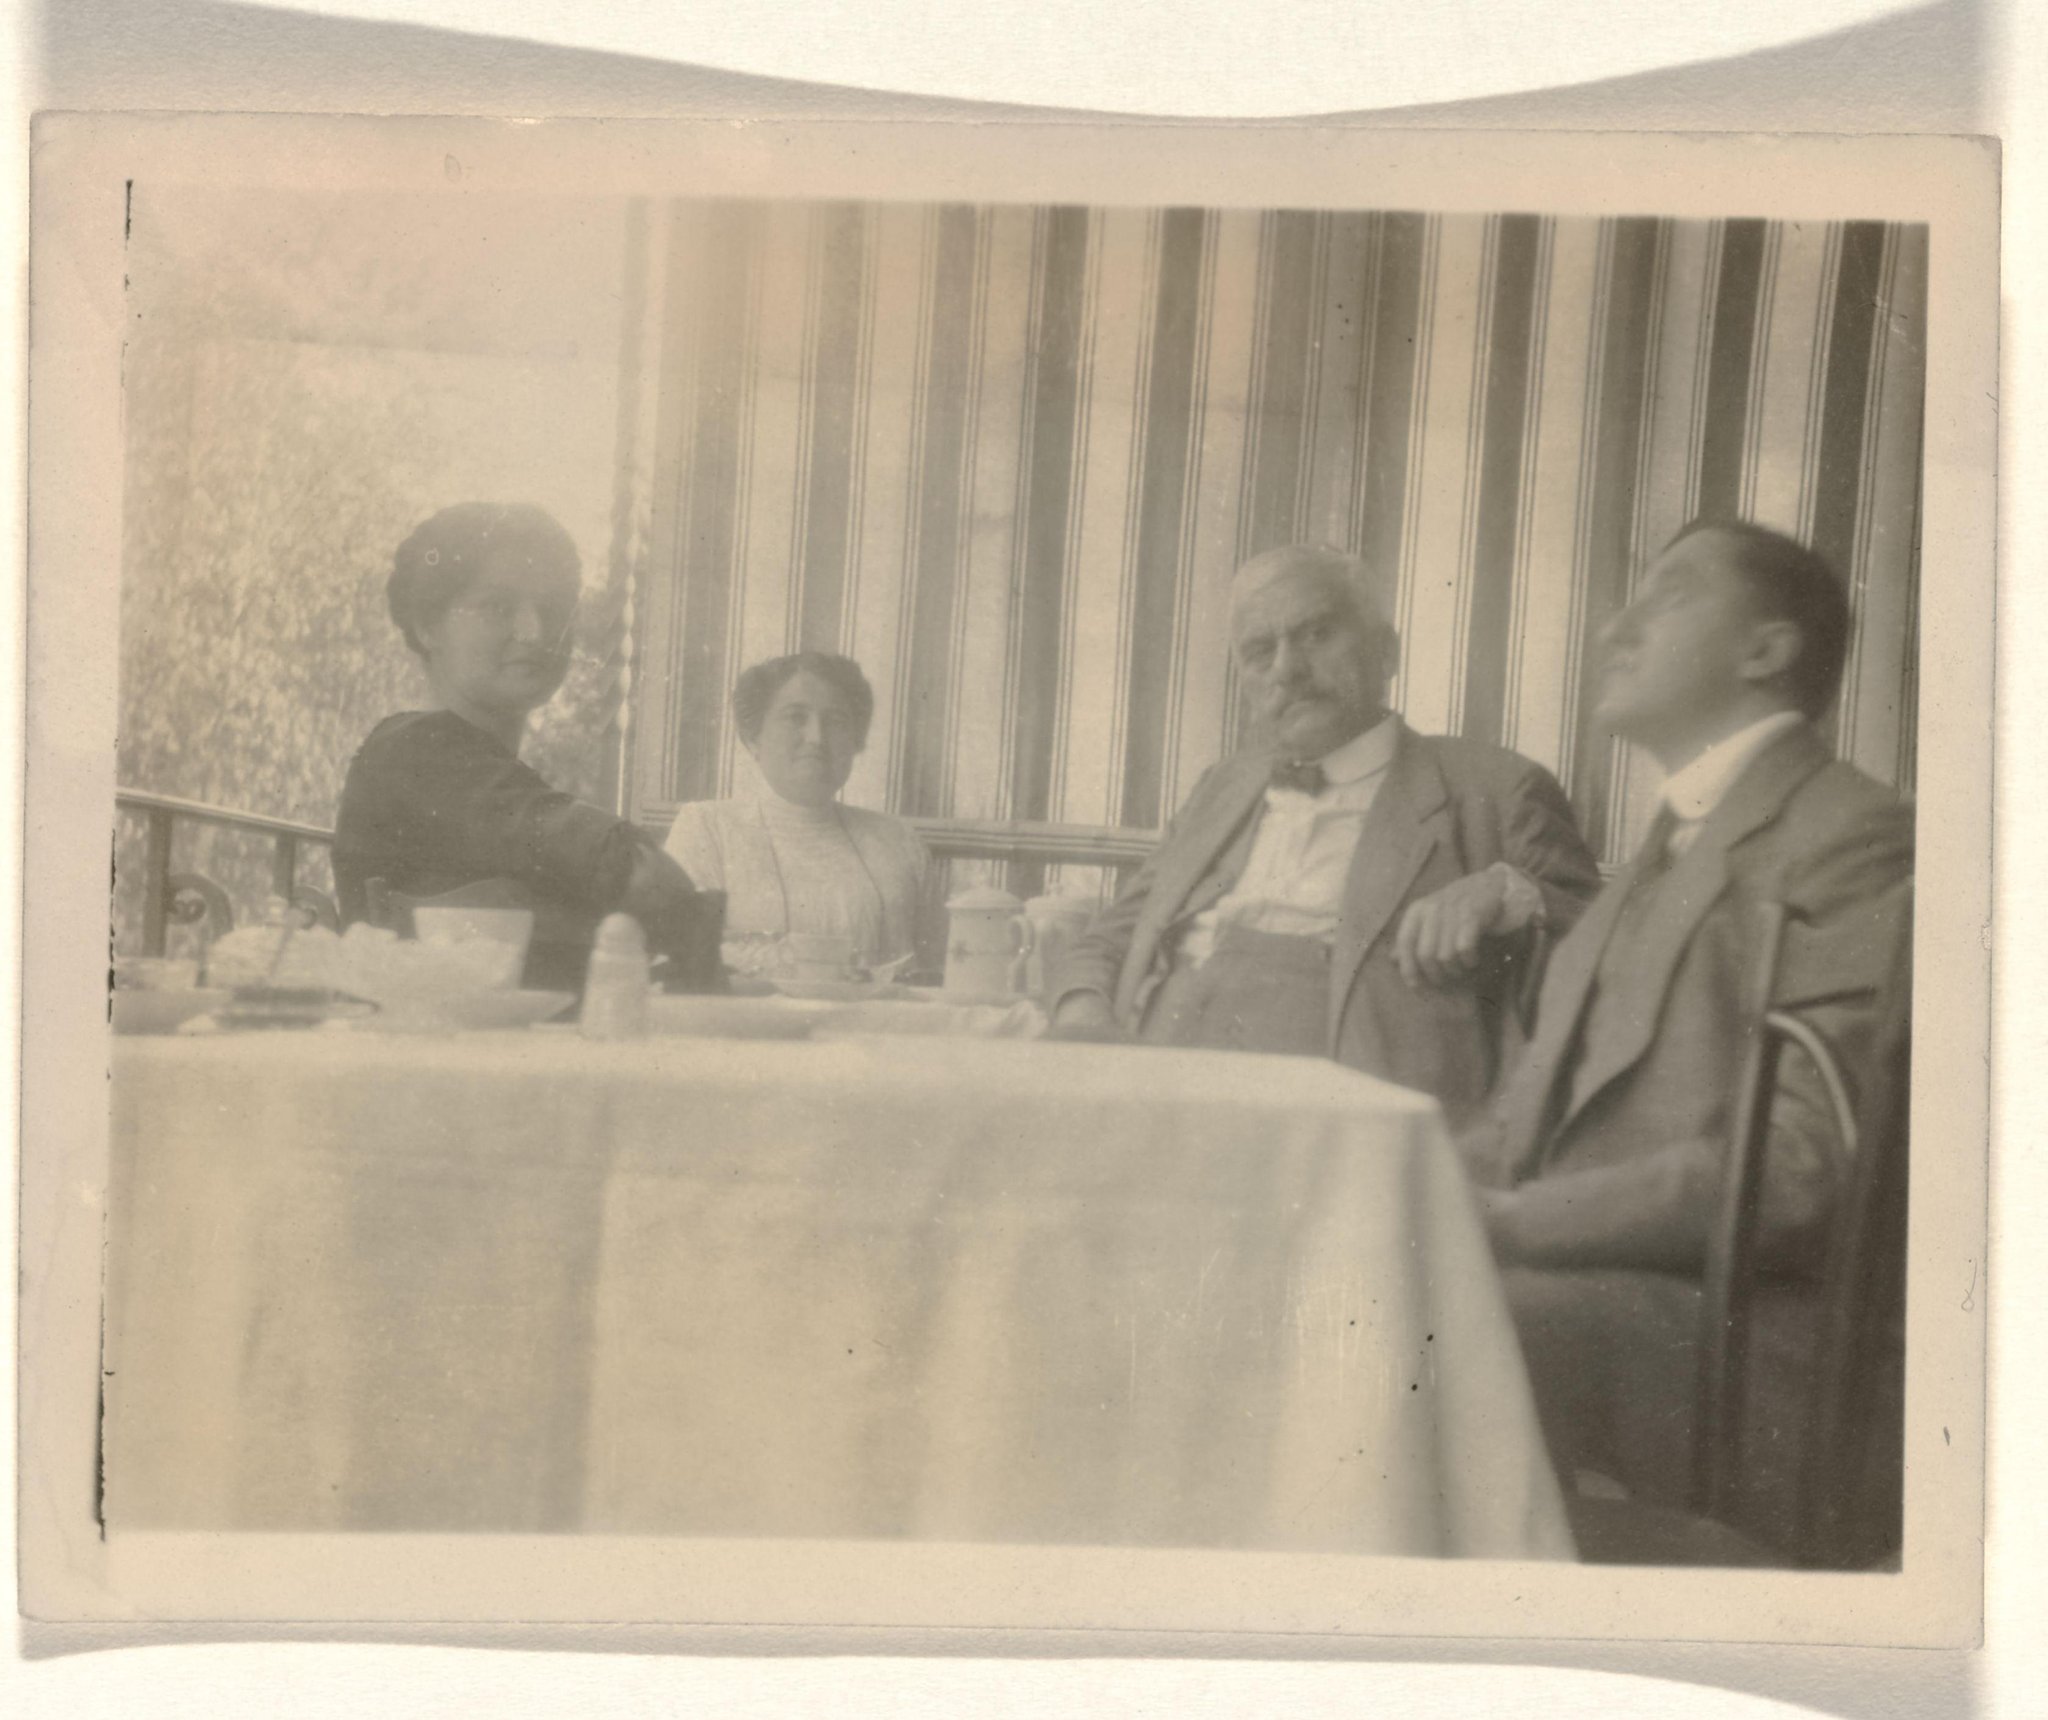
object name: photograph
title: Een onbekende vrouw, Mathilde Wachenheimer-Wertheimer, Meir Wachenheimer en Eugen Wachenheimer gezeten aan een gedekte tafel met tafelkleed daarover heen, met een muur met gestreept behang op de achtergrond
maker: Anonymous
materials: photographic support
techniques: gelatin silver print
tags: eugen wachenheimer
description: Een onbekende vrouw (links), Mathilde Wachenheimer-Wertheimer (tweede van links), Meir Wachenheimer (tweede van rechts) en Eugen Wachenheimer (rechts) gezeten aan een gedekte tafel met tafelkleed.